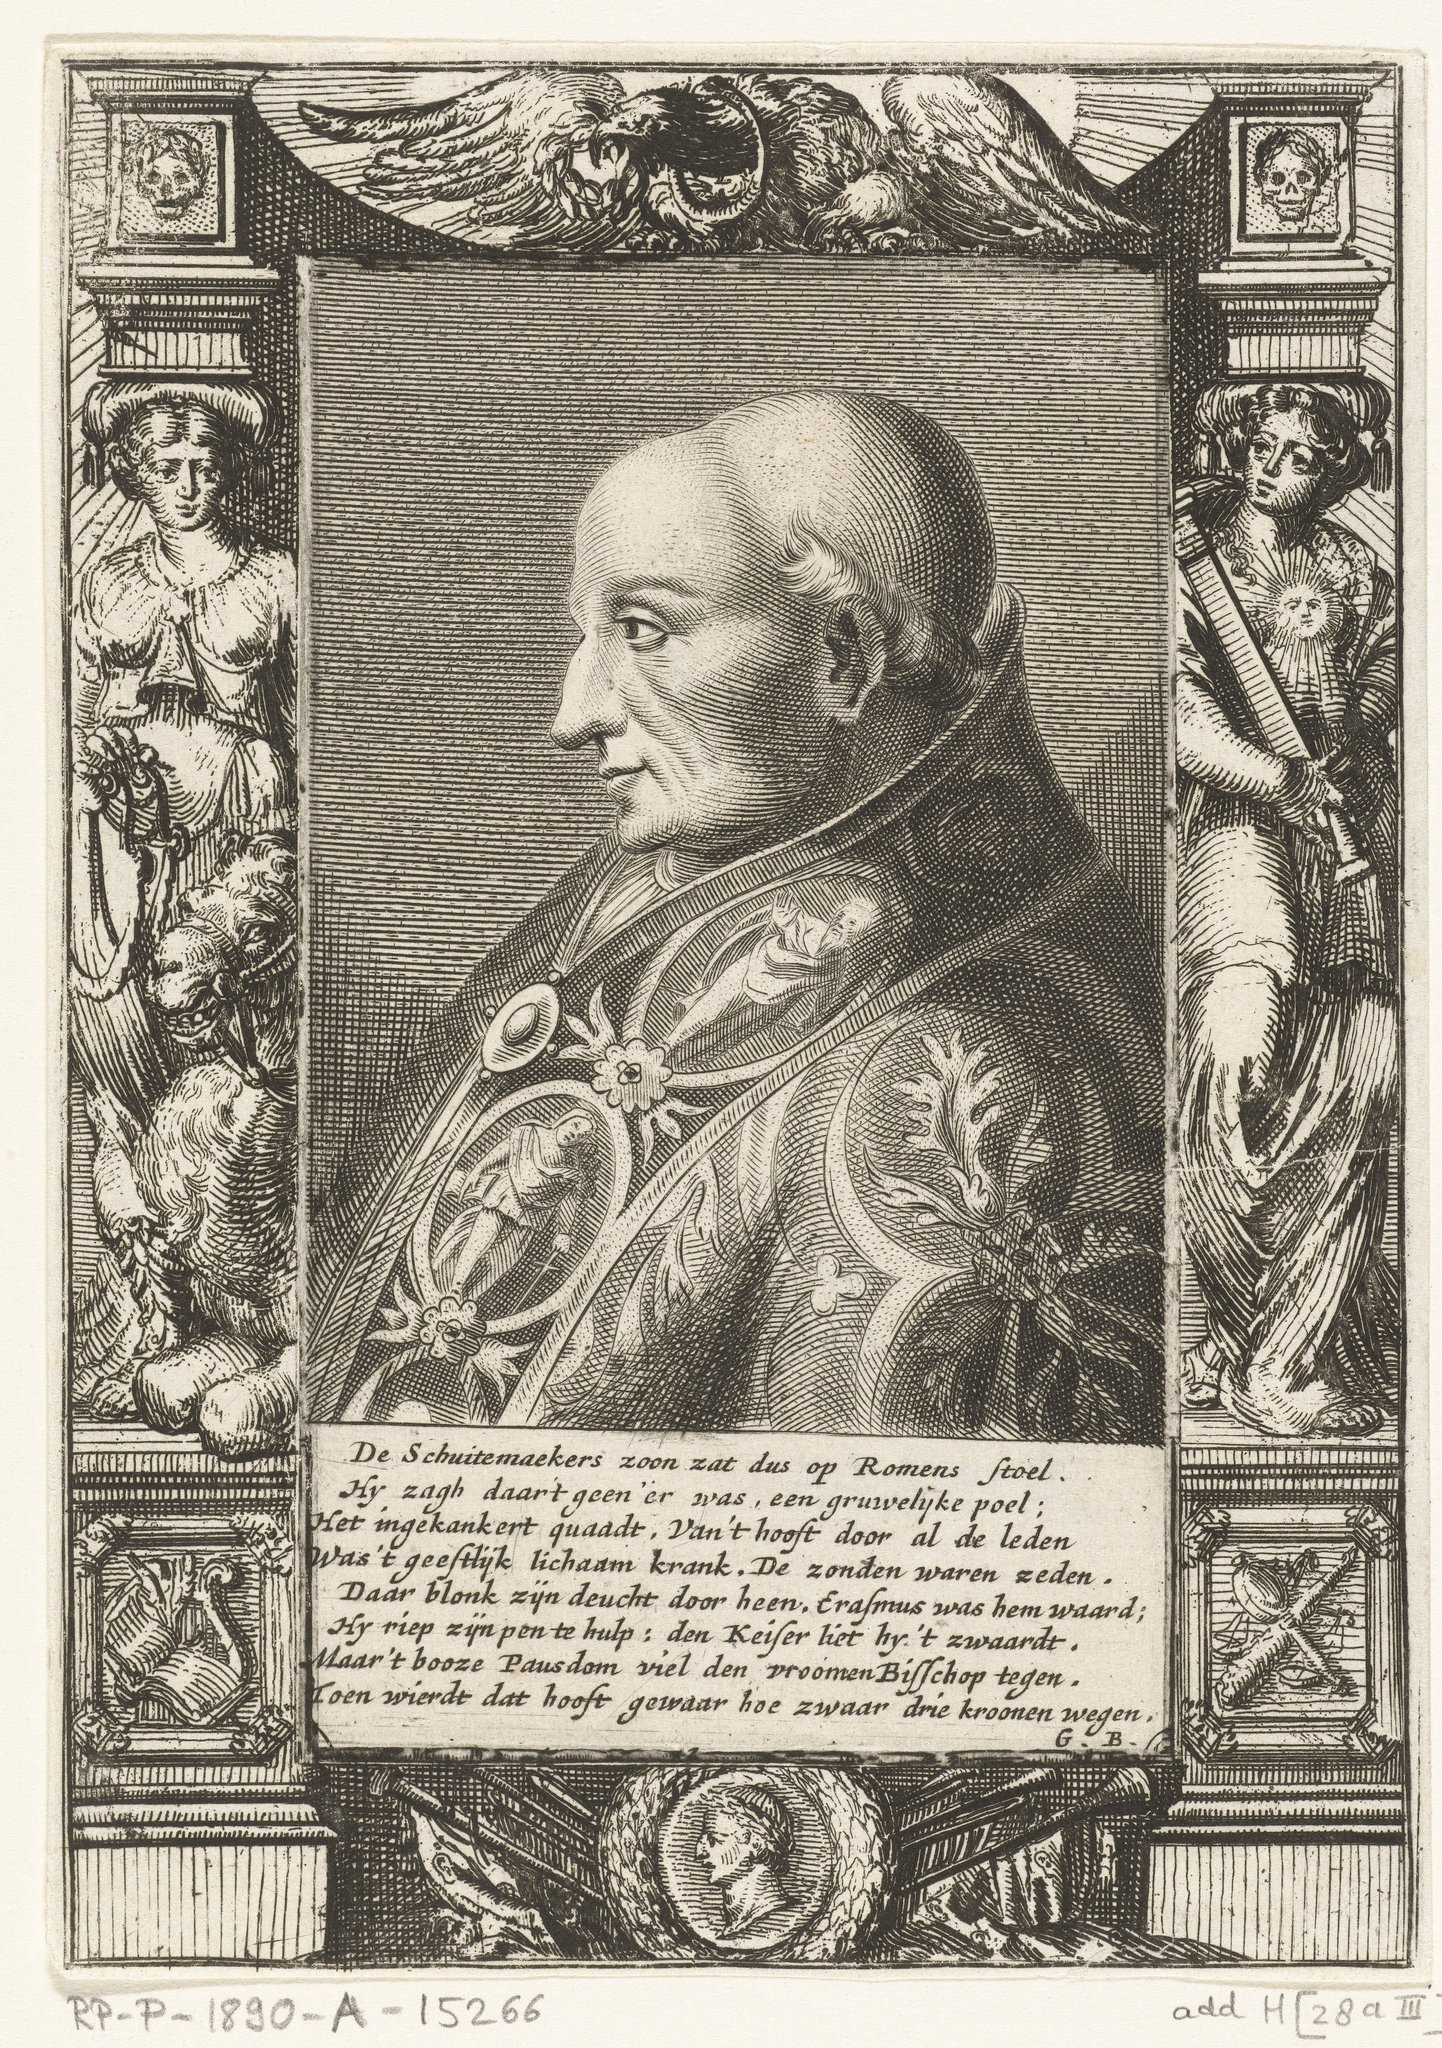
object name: book illustration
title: Portret van paus Adrianus VI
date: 1657-1707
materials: paper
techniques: engraving, etching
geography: netherlands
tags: rome, clergyman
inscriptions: collector's mark: Lugt 2228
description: Prent gedrukt van twee platen. Portretbuste van paus Adrianus VI met een rijk versierde mantel aan. Onder de voorstelling een vers van acht regels in het Nederlands. Omlijsting met allegorische figuren en symbolen.